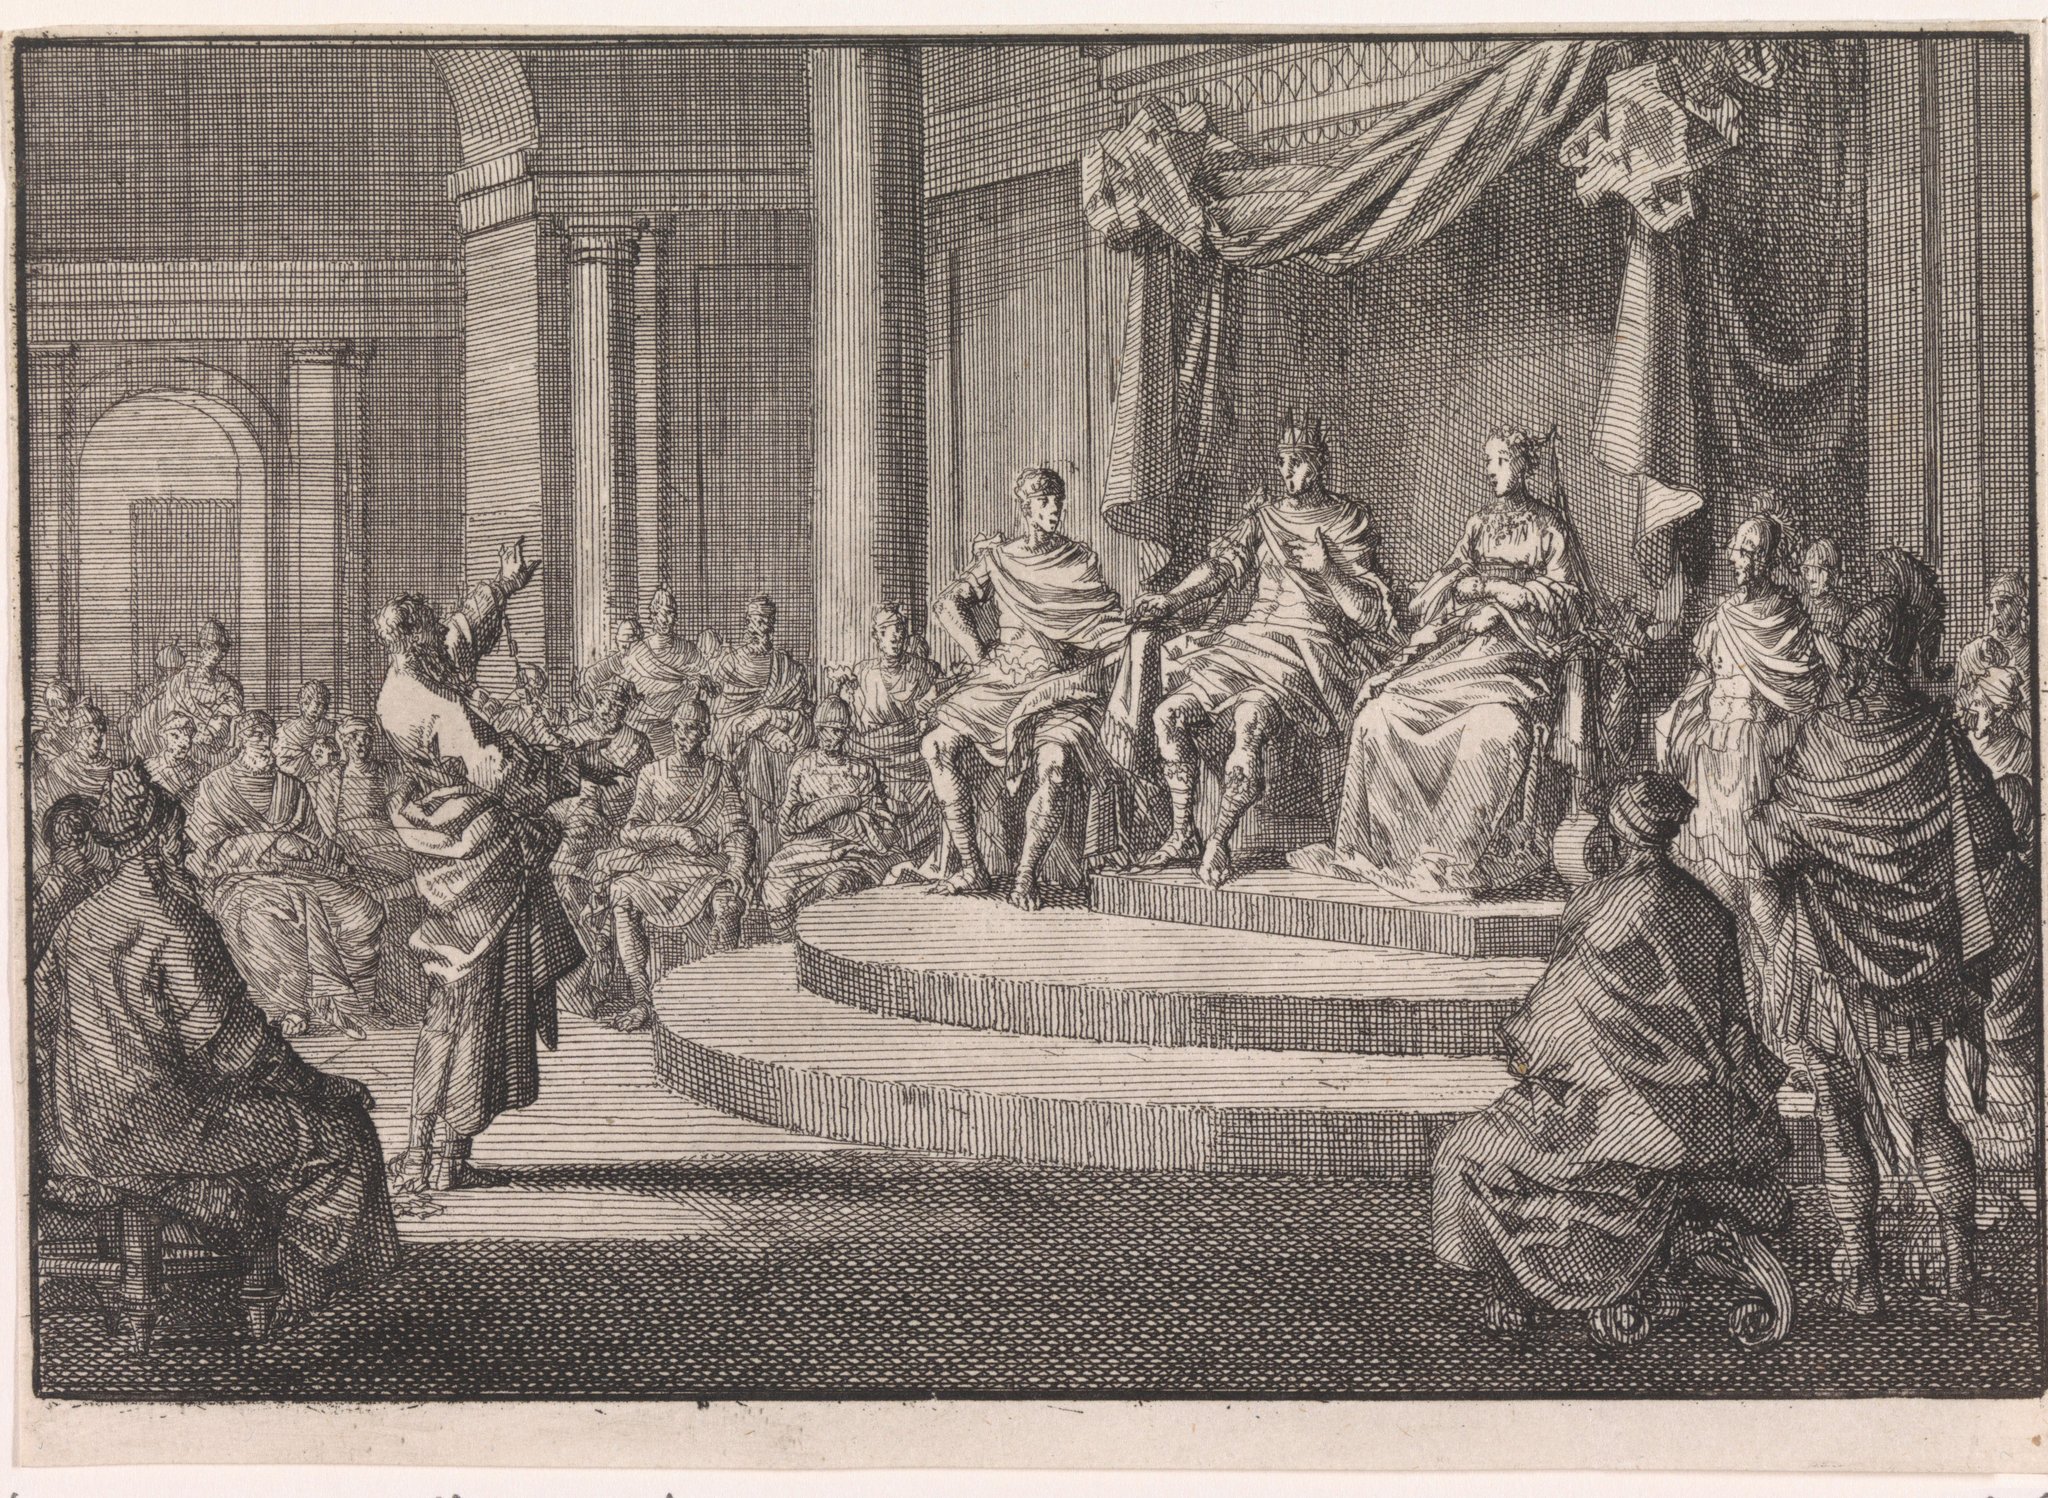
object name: print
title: Paulus geketend voor koning Agrippa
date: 1703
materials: paper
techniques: etching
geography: amsterdam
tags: paul before festus, king agrippa and queen bernice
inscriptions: collector's mark: Lugt 2228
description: Proefdruk van een boekillustratie voor David Martin. Historie des Ouden en Nieuwen Testaments. Amsterdam, Pieter Mortier, 1703. Deel II. De boekillustraties voor de Mortierbijbel hebben verschillende staten en kopieën, waarbij de chronologische volgorde moeilijk te achterhalen valt. Als boekillustraties werden ze bovendien herhaaldelijk opnieuw gebruikt voor andere boekwerken